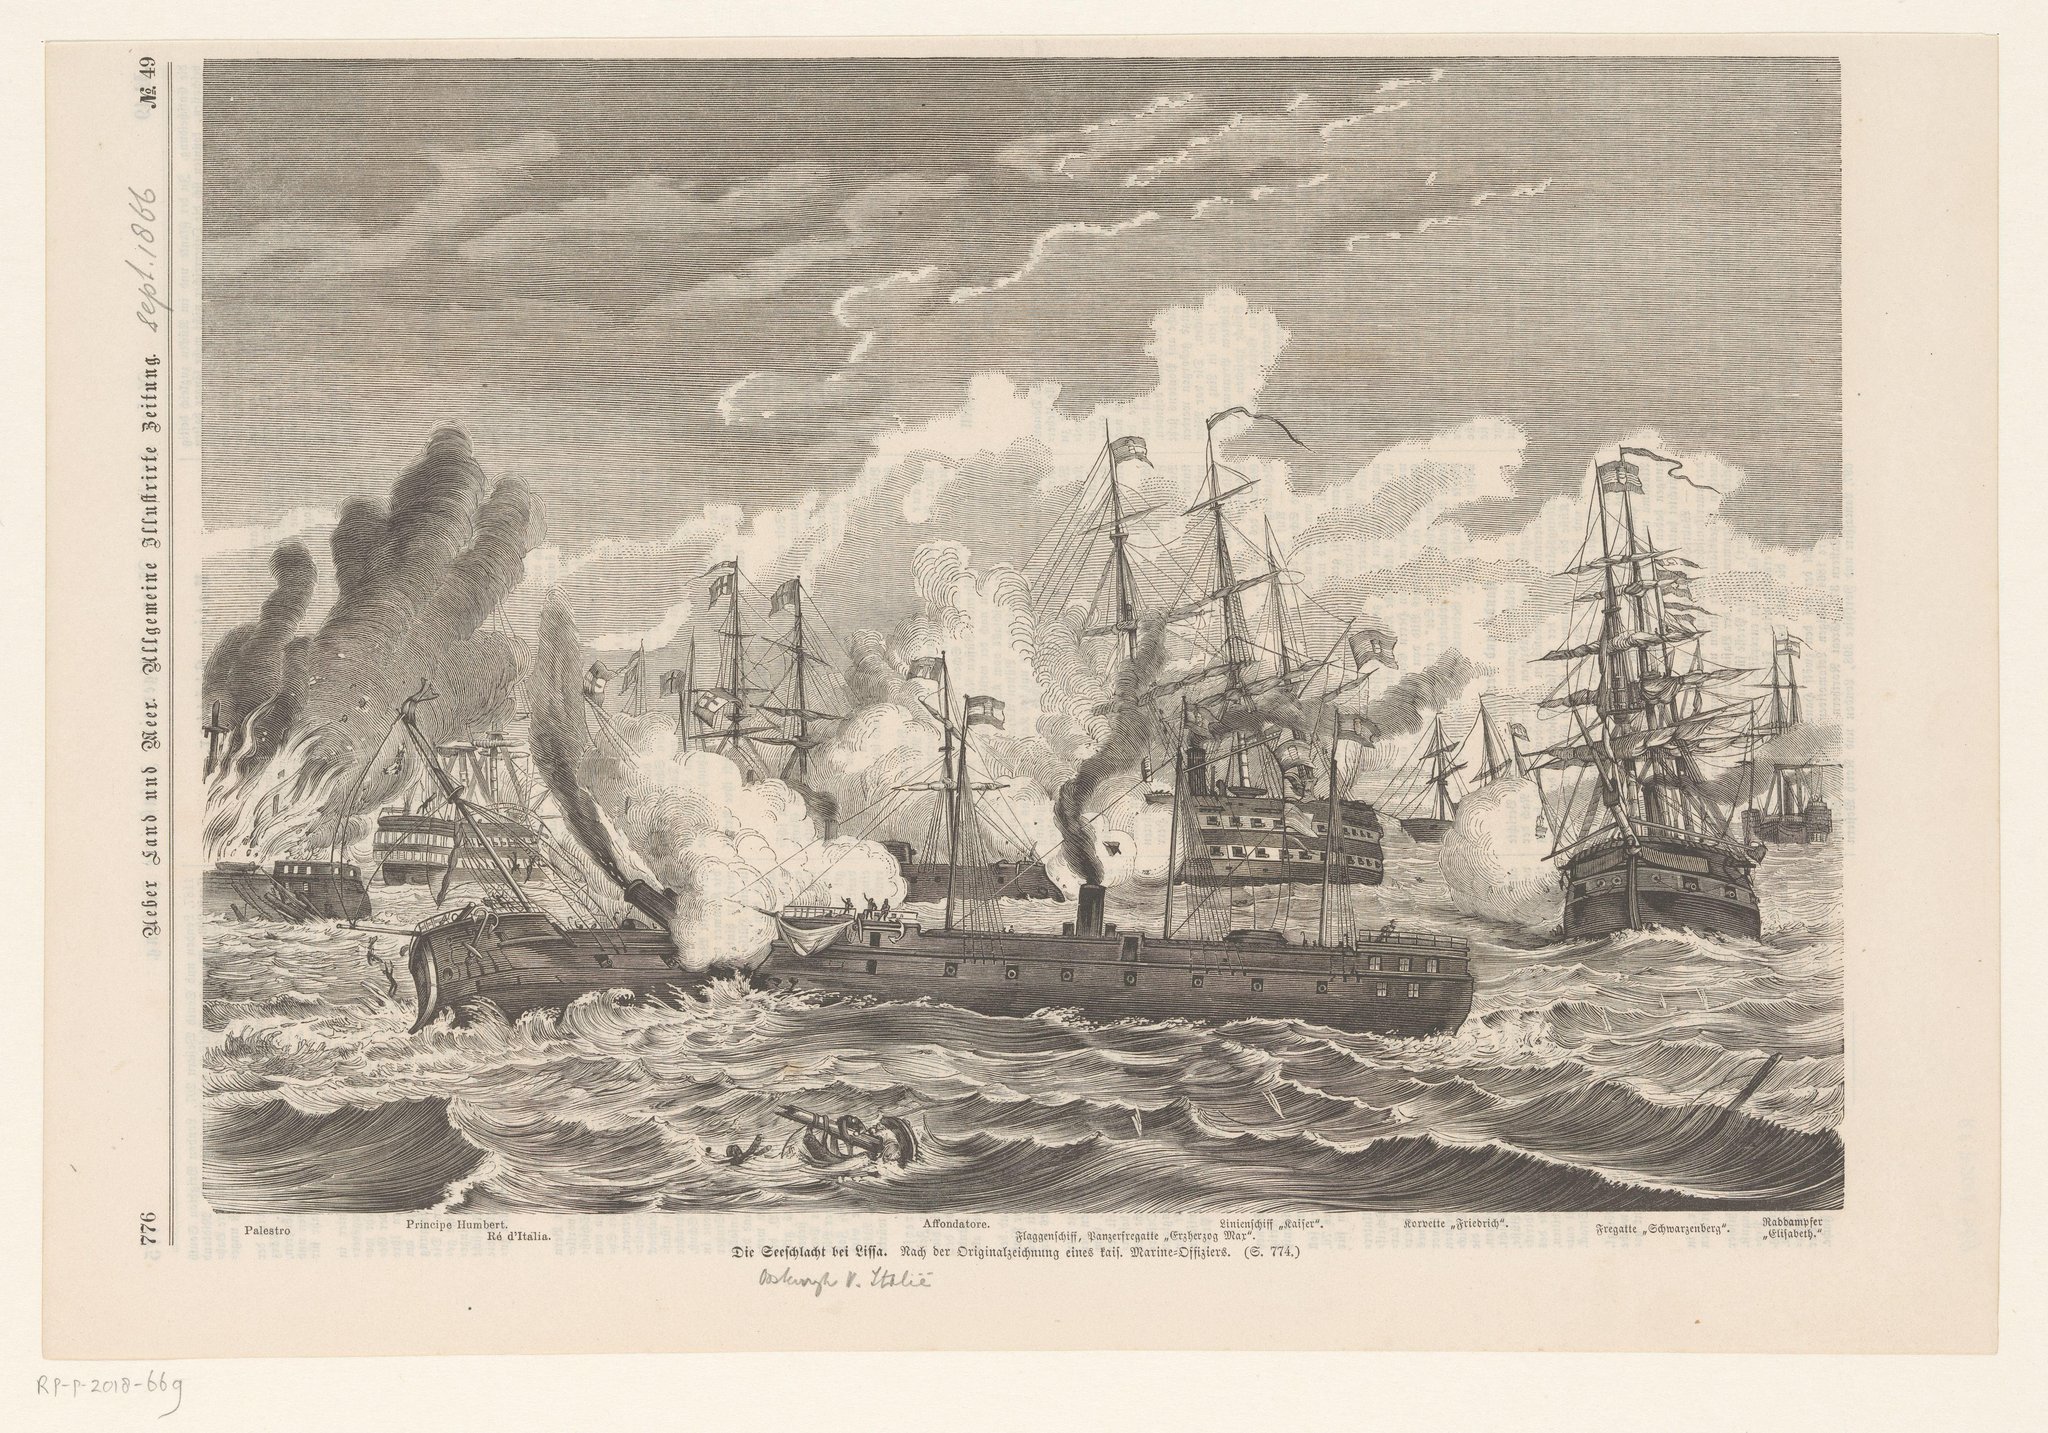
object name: print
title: Die Seeschlacht bei Lissa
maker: Anonymous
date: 1809-1866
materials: paper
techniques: engraving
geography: germany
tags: battle (+ naval force)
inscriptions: collector's mark: Lugt 2228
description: De Slag bij Lissa op 20 juli 1866 waarbij de Oostenrijkse vloot won van de Italiaanse vloot. Onderdeel van de Pruisisch-Oostenrijkse Oorlog.